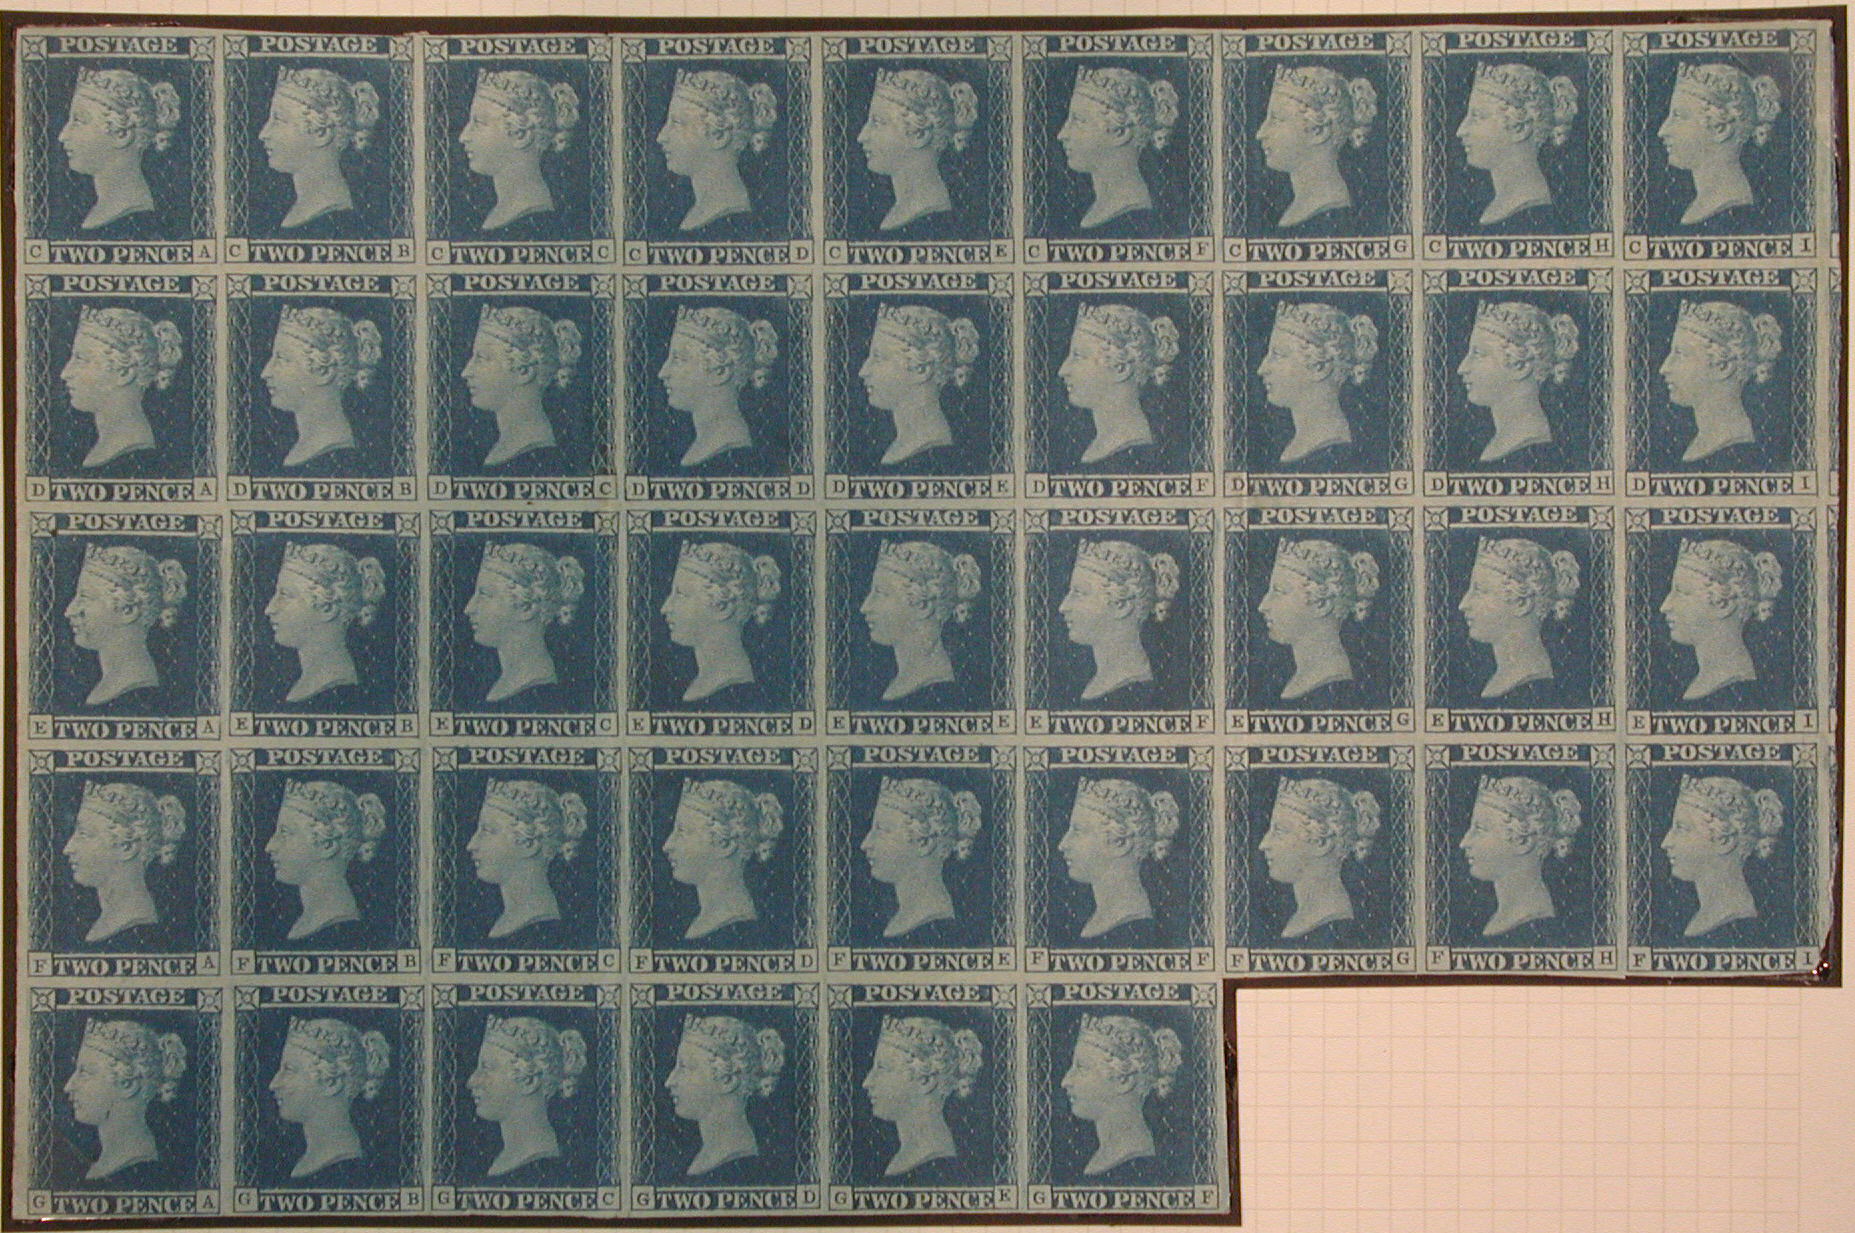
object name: postage stamp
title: Unused block of forty-two "Two Penny Blue" postage stamps of Queen Victoria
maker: william wyon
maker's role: artist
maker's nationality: british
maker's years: 1795-1851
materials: ink, paper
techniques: engraving, printing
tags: profiles,women,queen victoria